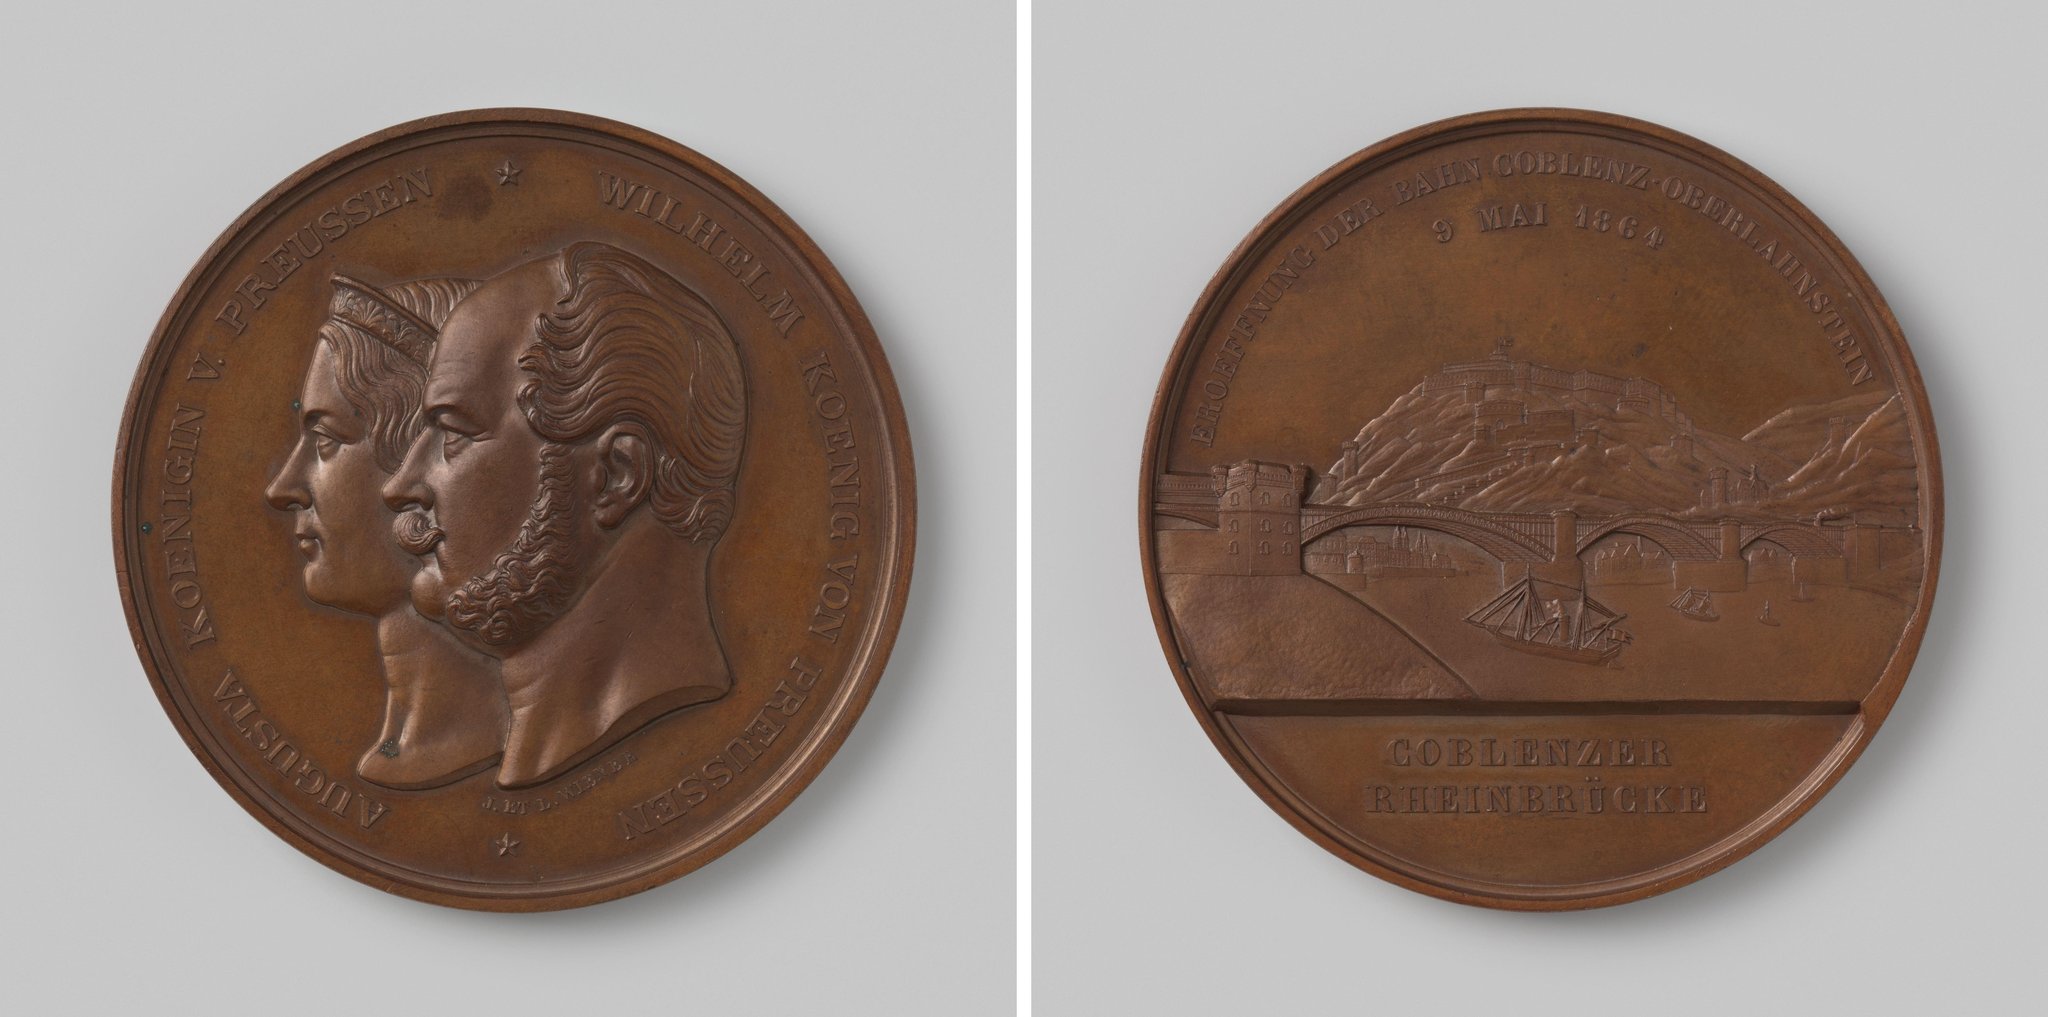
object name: history medal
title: Opening van de spoorweg Coblenz - Oberlahnstein 1864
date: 1864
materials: bronze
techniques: striking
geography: brussels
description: Bronzen penning, op de voorzijde de geconjugeerde portretten van Koningin Augusta en Koning Wilhelm I van Pruisen met omschrift, op de keerzijde een landschap met de spoorbrug over de Rijn bij Coblenz, met dubbel omschrift en afsnedetekst.